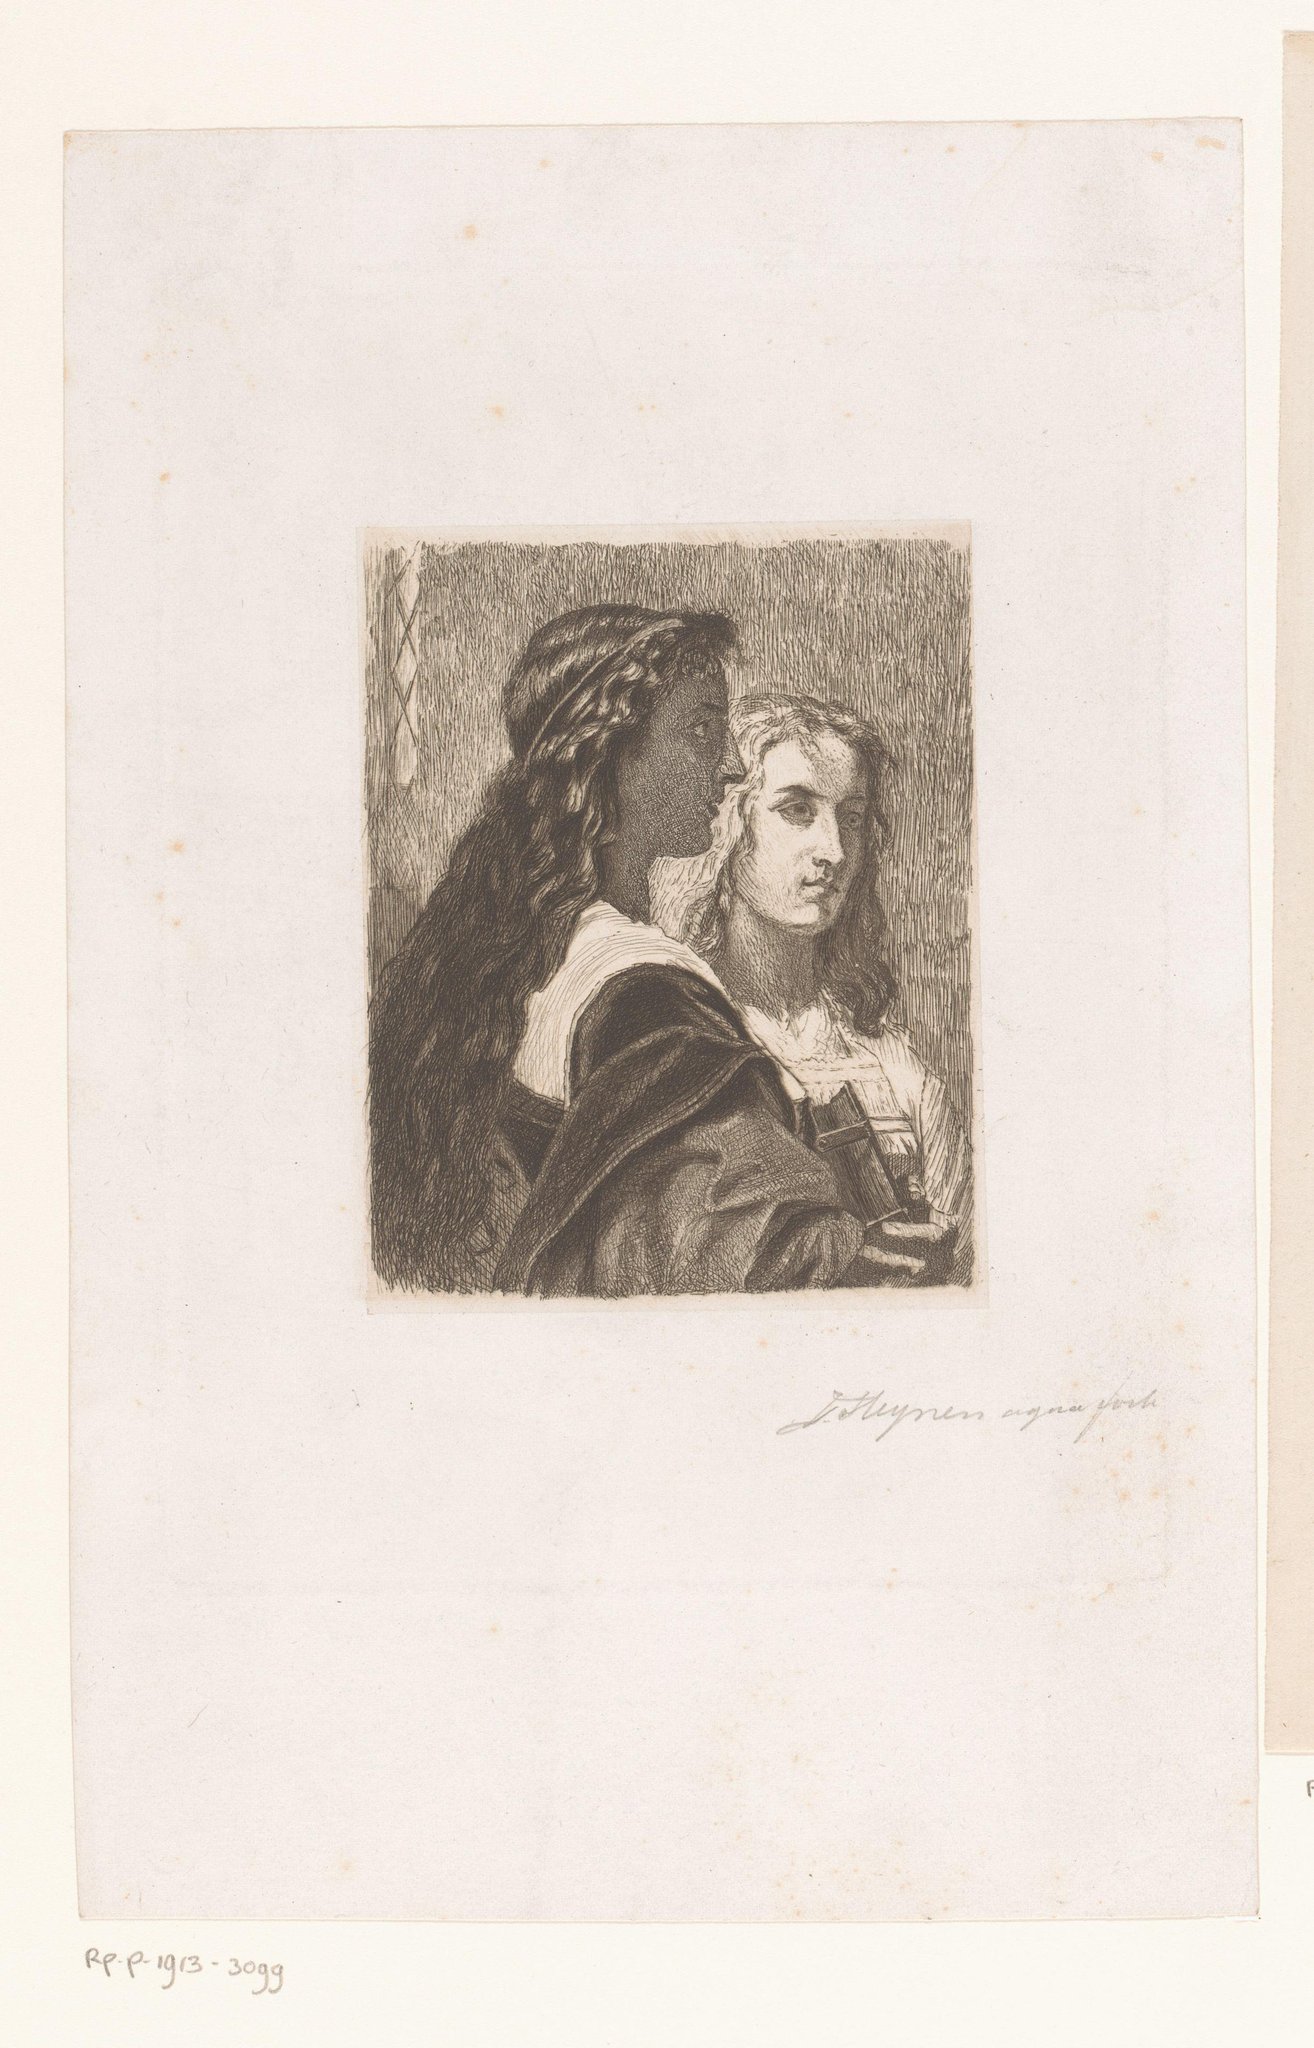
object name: print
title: Twee figuren, mogelijk Romeo en Julia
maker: joseph paul steynen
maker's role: print maker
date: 1850-1913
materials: paper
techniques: etching, intaglio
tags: romeo, juliet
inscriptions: collector's mark: Lugt 2228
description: In de inventaris getiteld: Romeo en Julia.